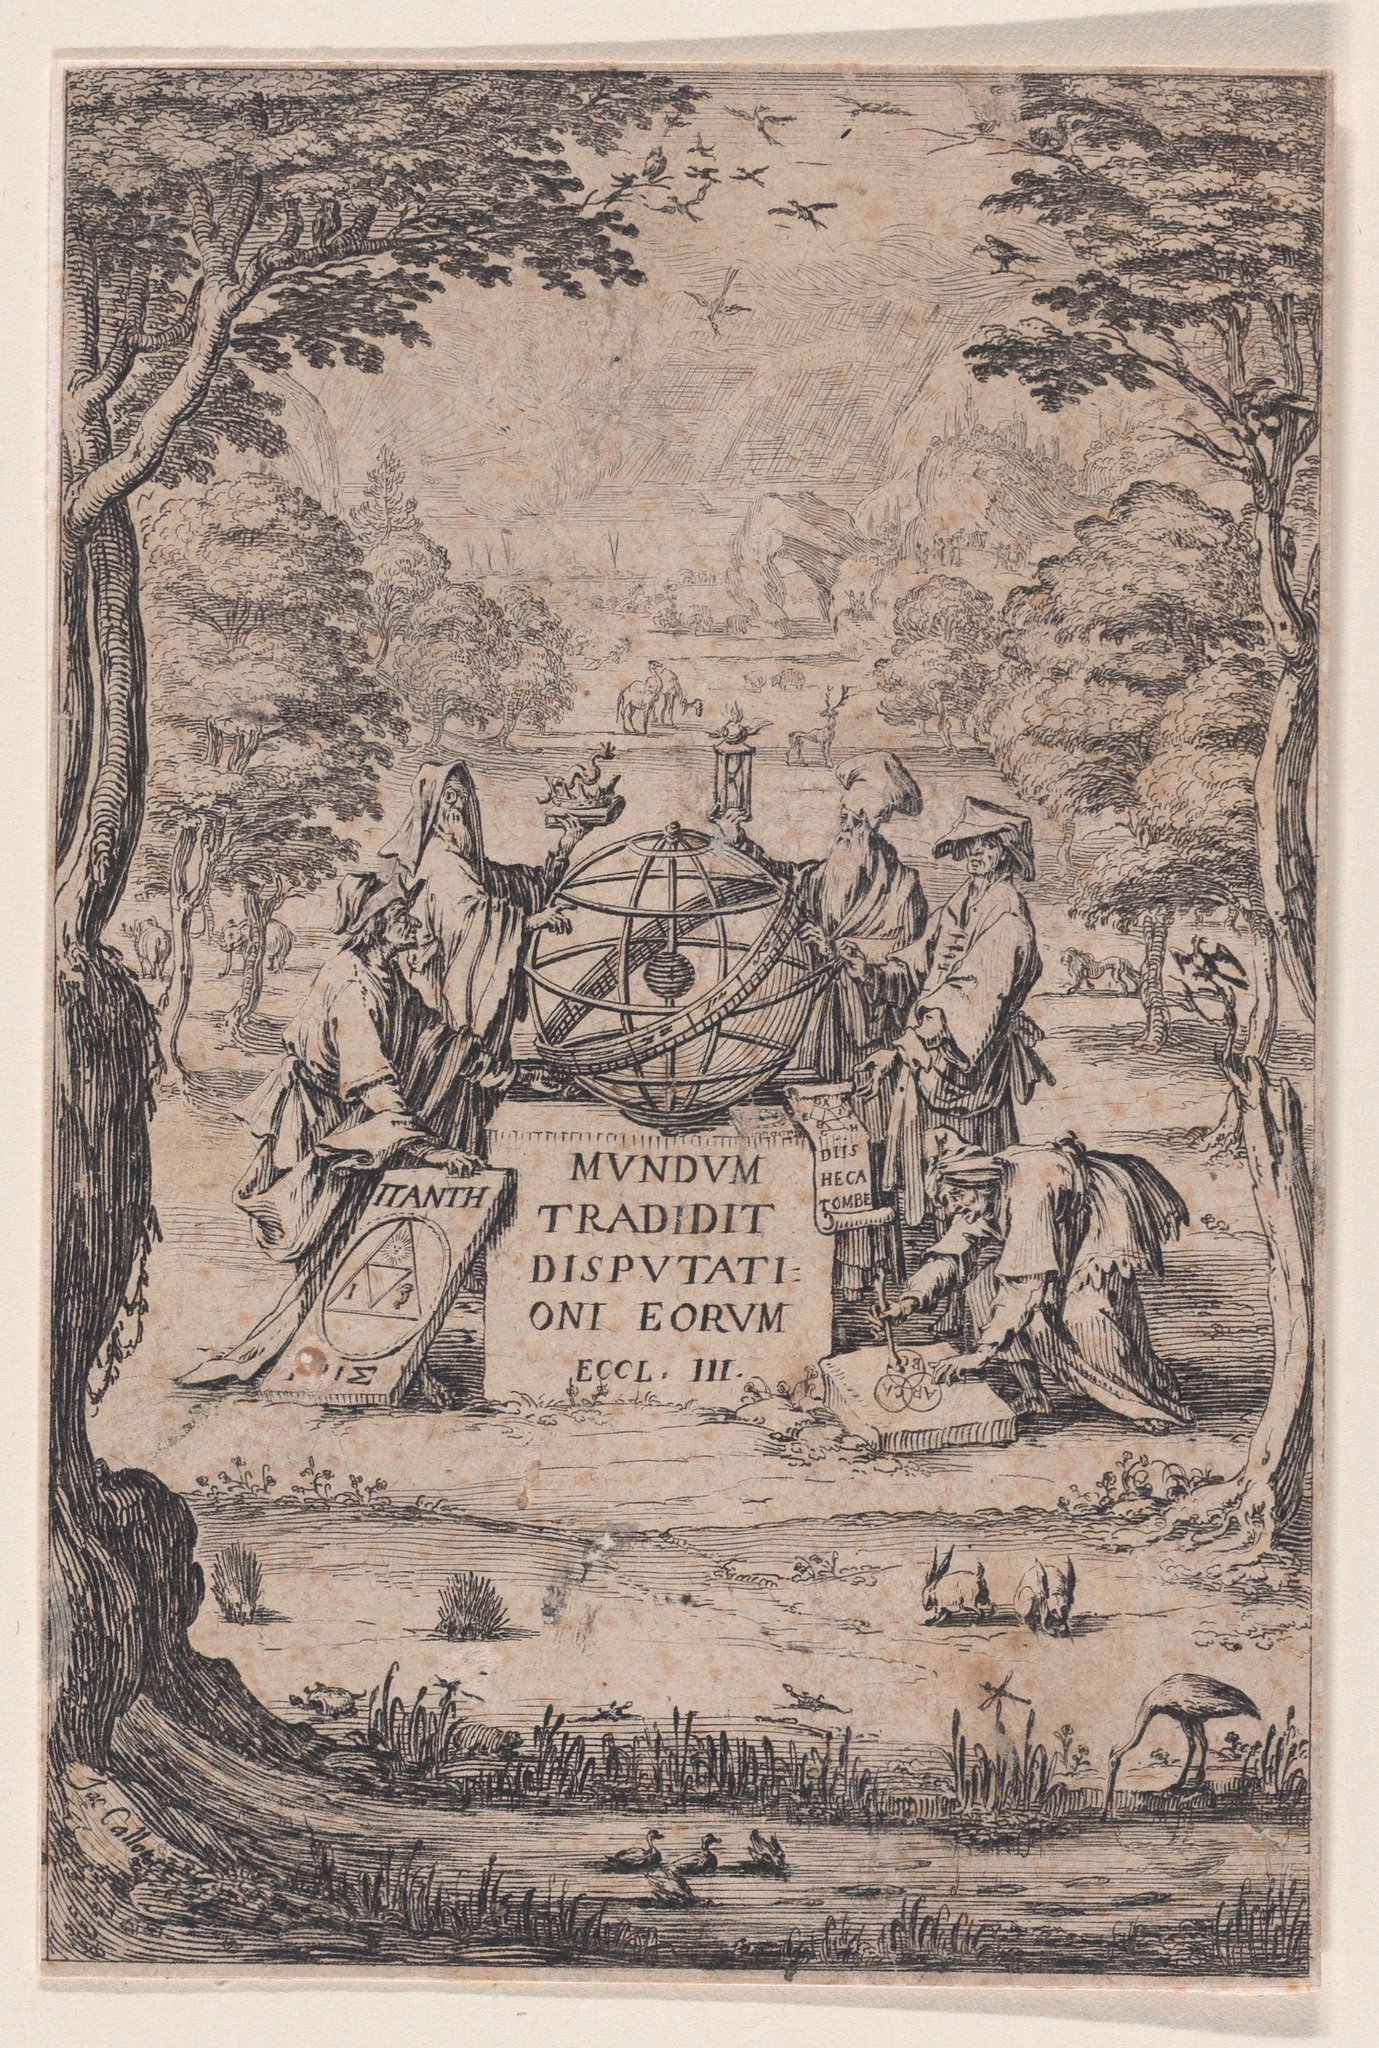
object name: print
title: Frontispiece, from "Sacra Cosmologia, pièce appelée aussi Le Titre aux Astrologues" (Sacra Cosmologia, also called The Title Page for The Astrologers)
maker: jacques callot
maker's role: artist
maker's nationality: french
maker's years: 1592-1635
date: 1630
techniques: etching